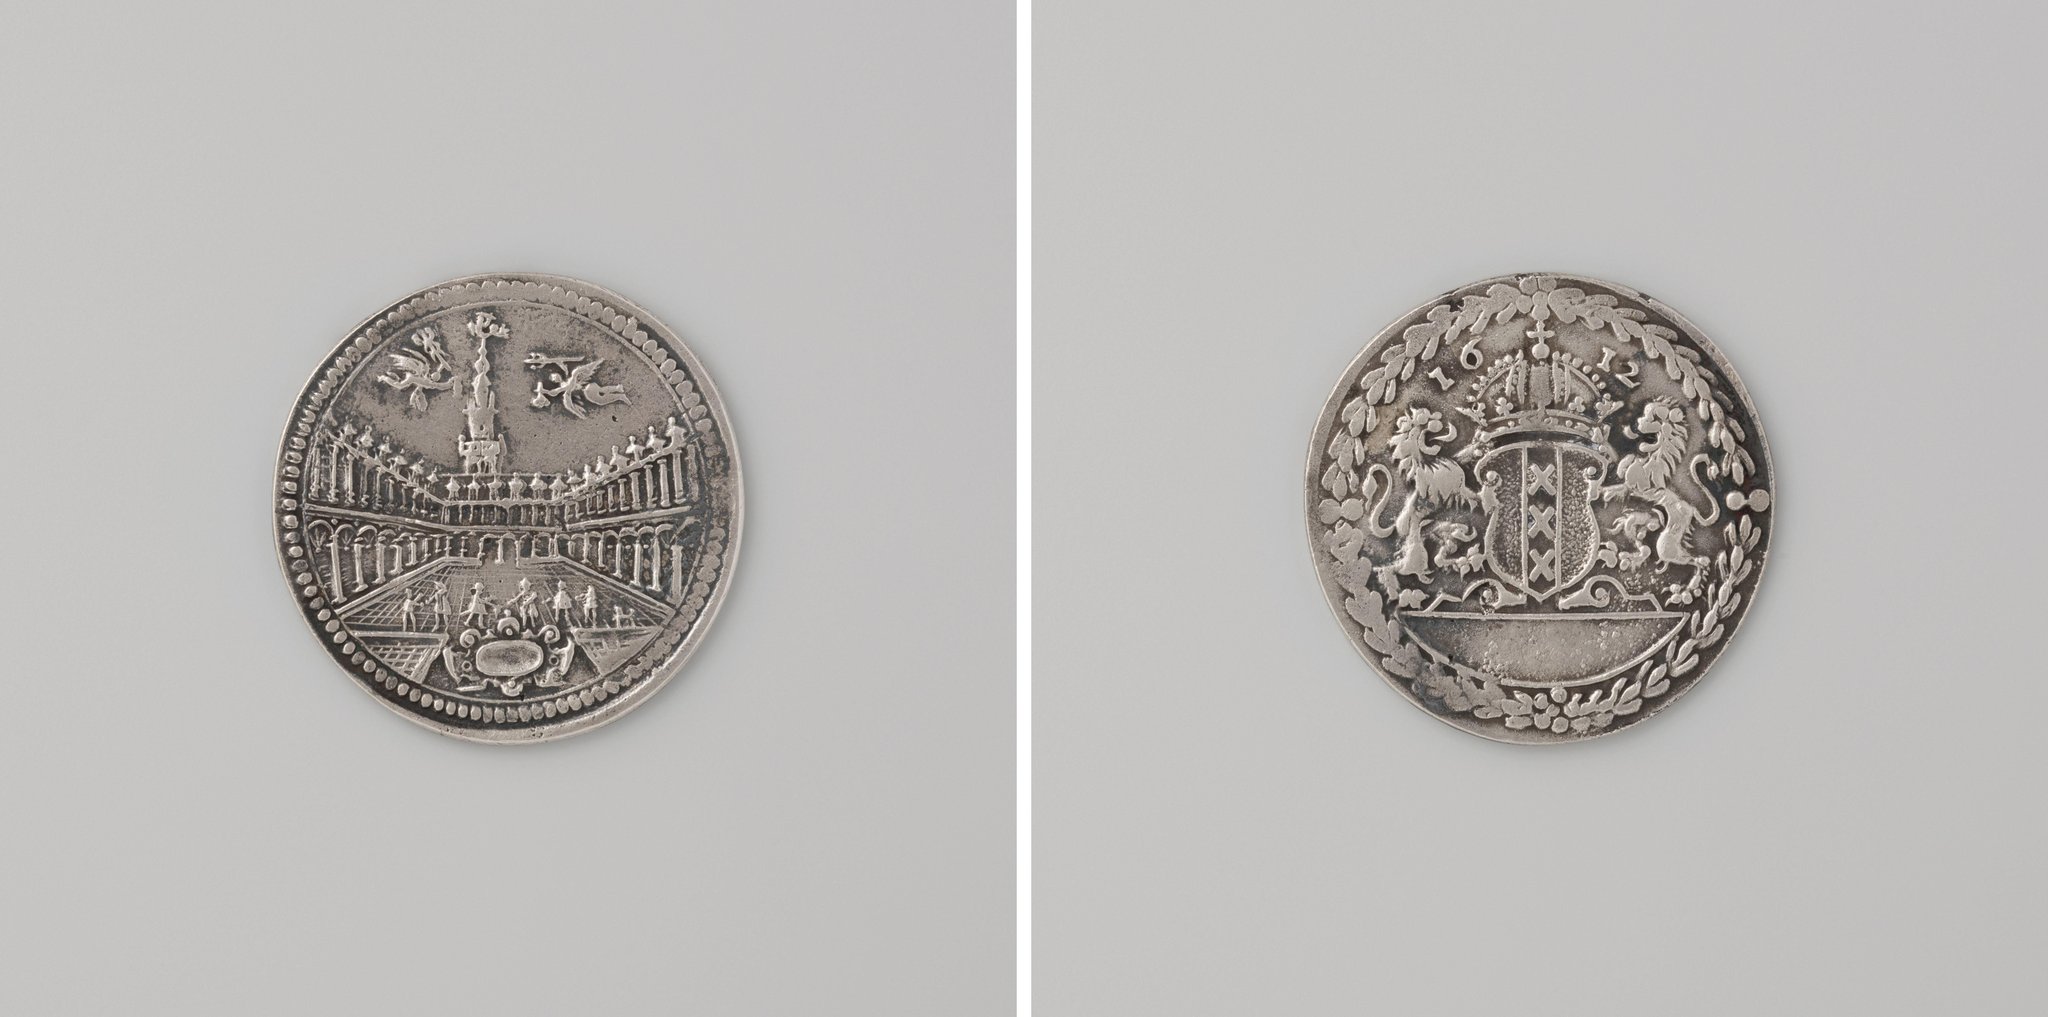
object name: history medal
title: De makelaars te Amsterdam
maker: Anonymous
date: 1612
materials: silver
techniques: striking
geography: amsterdam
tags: amsterdam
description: Zilveren penning. Voorzijde: pas opgerichte beursgebouw met daarboven vliegende Mercurius. Keerzijde: gekroond wapen van Amsterdam met twee leeuwen.